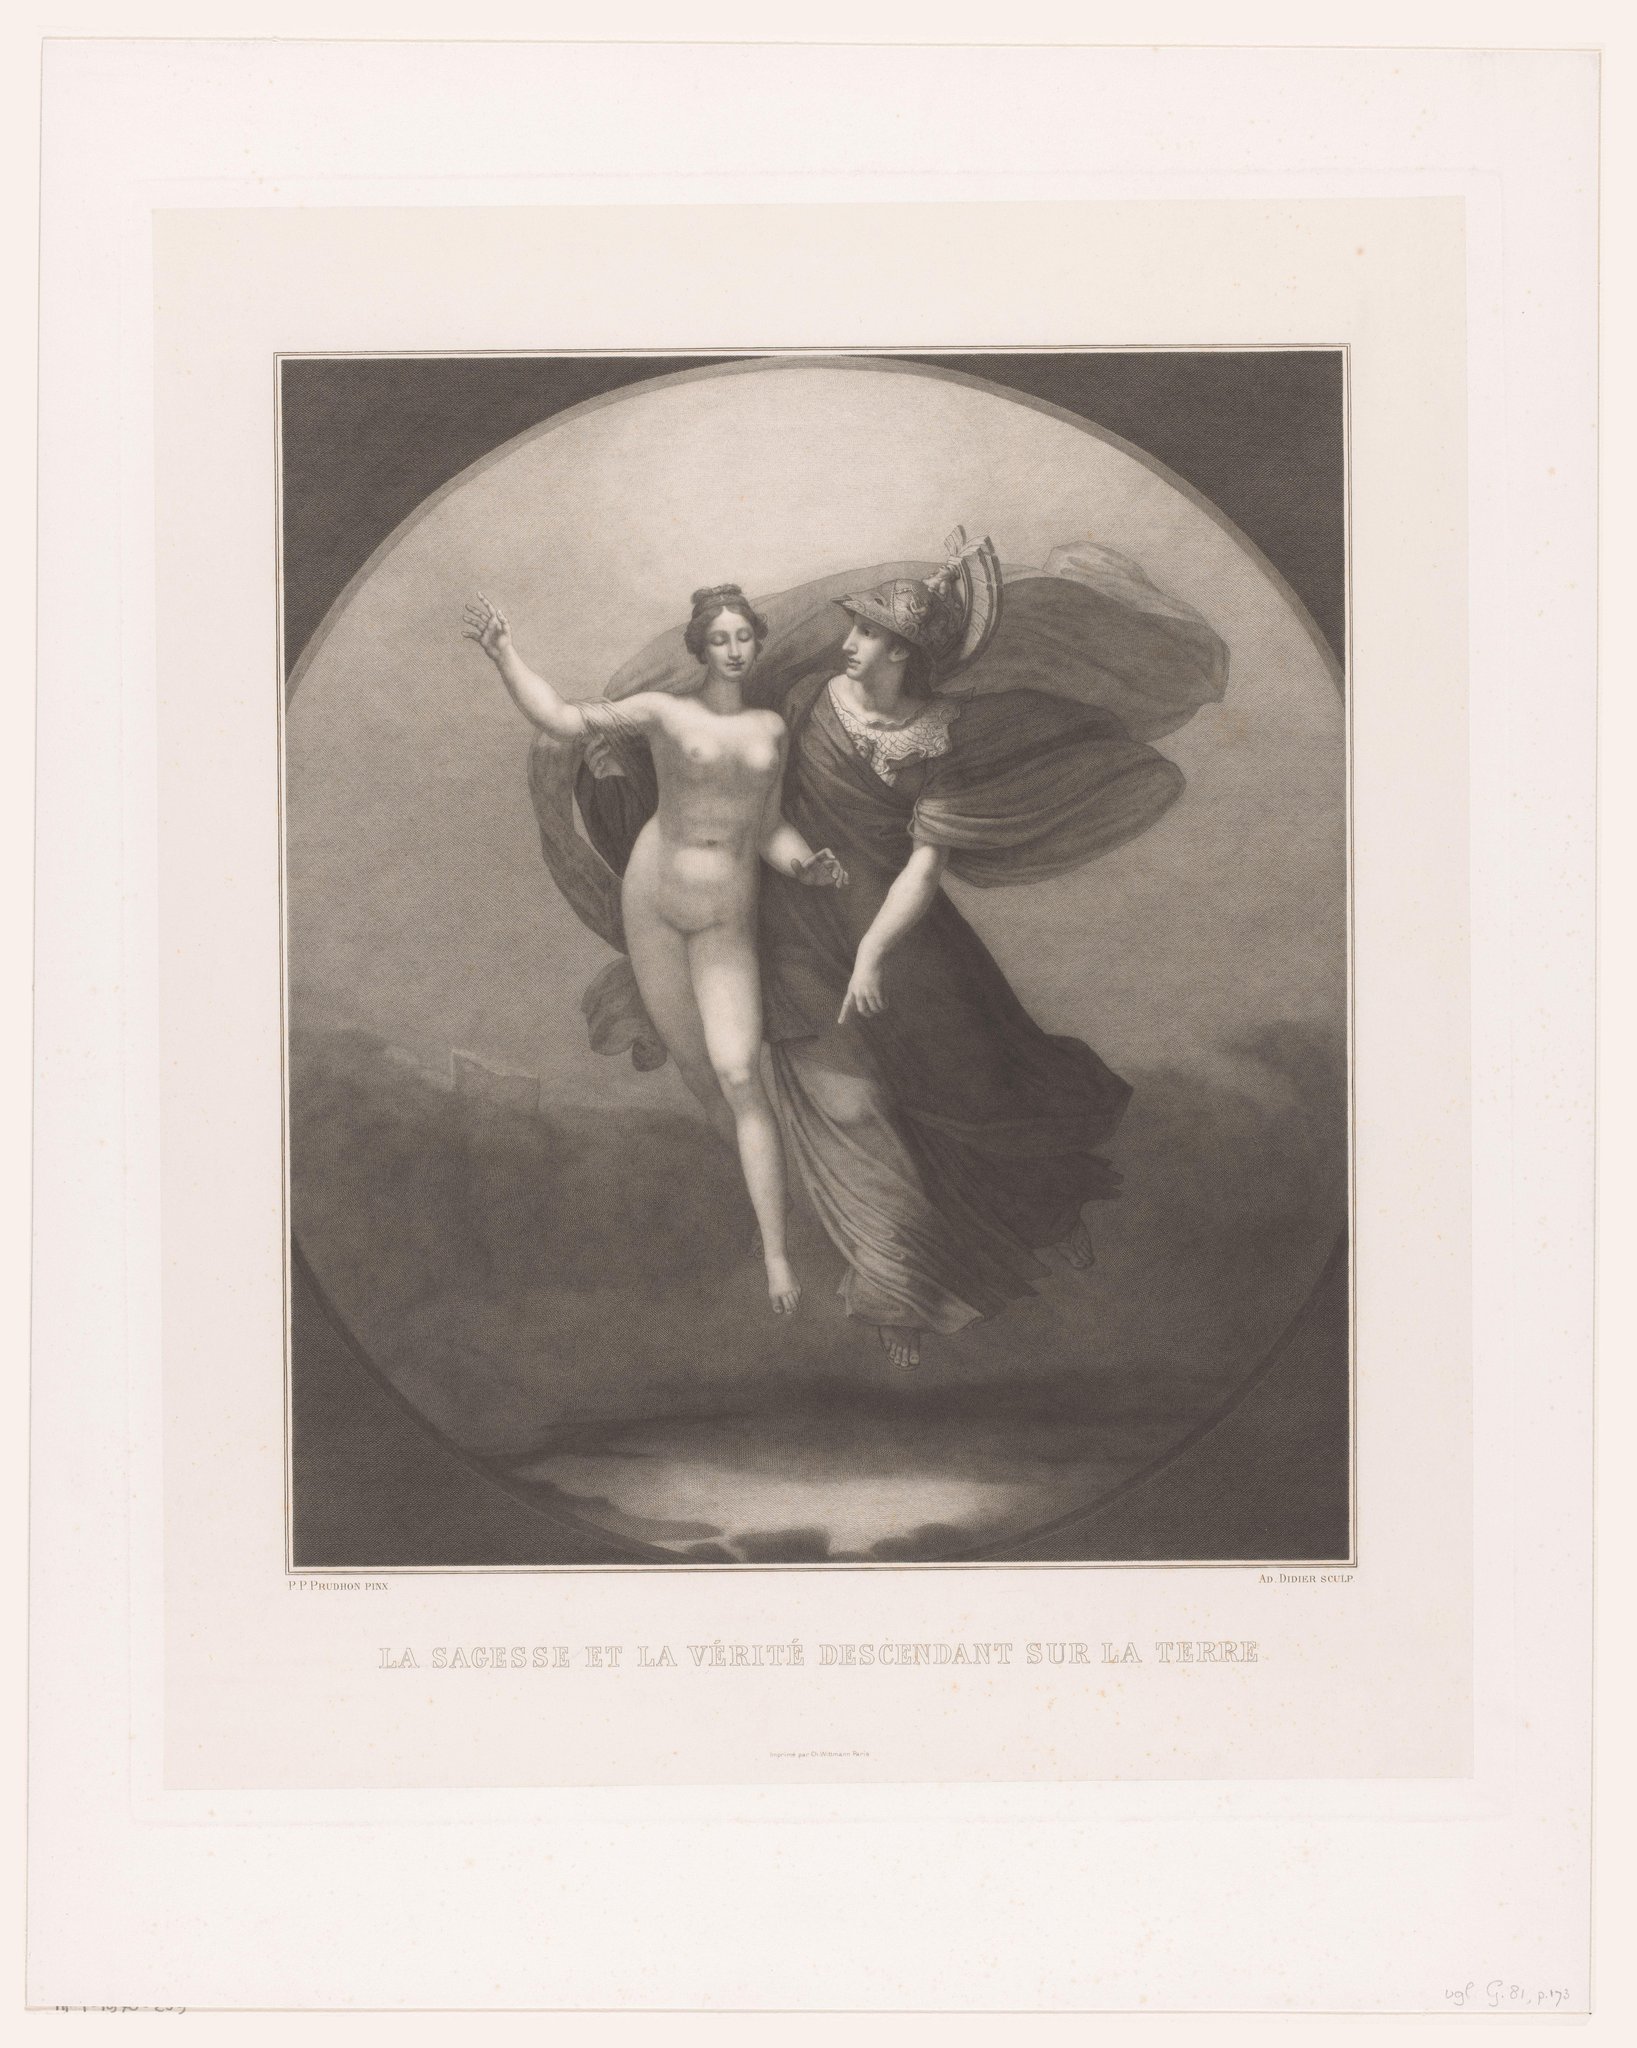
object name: print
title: Wijsheid en Waarheid dalen neer op aarde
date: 1853-1895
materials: paper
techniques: engraving, etching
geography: paris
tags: (story of) minerva (pallas, athena), wisdom; 'sapienza', 'sapienza humana', 'sapienza vera' (ripa), truth; 'verità' (ripa)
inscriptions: collector's mark: Lugt 2228, collector's mark: Lugt 2760